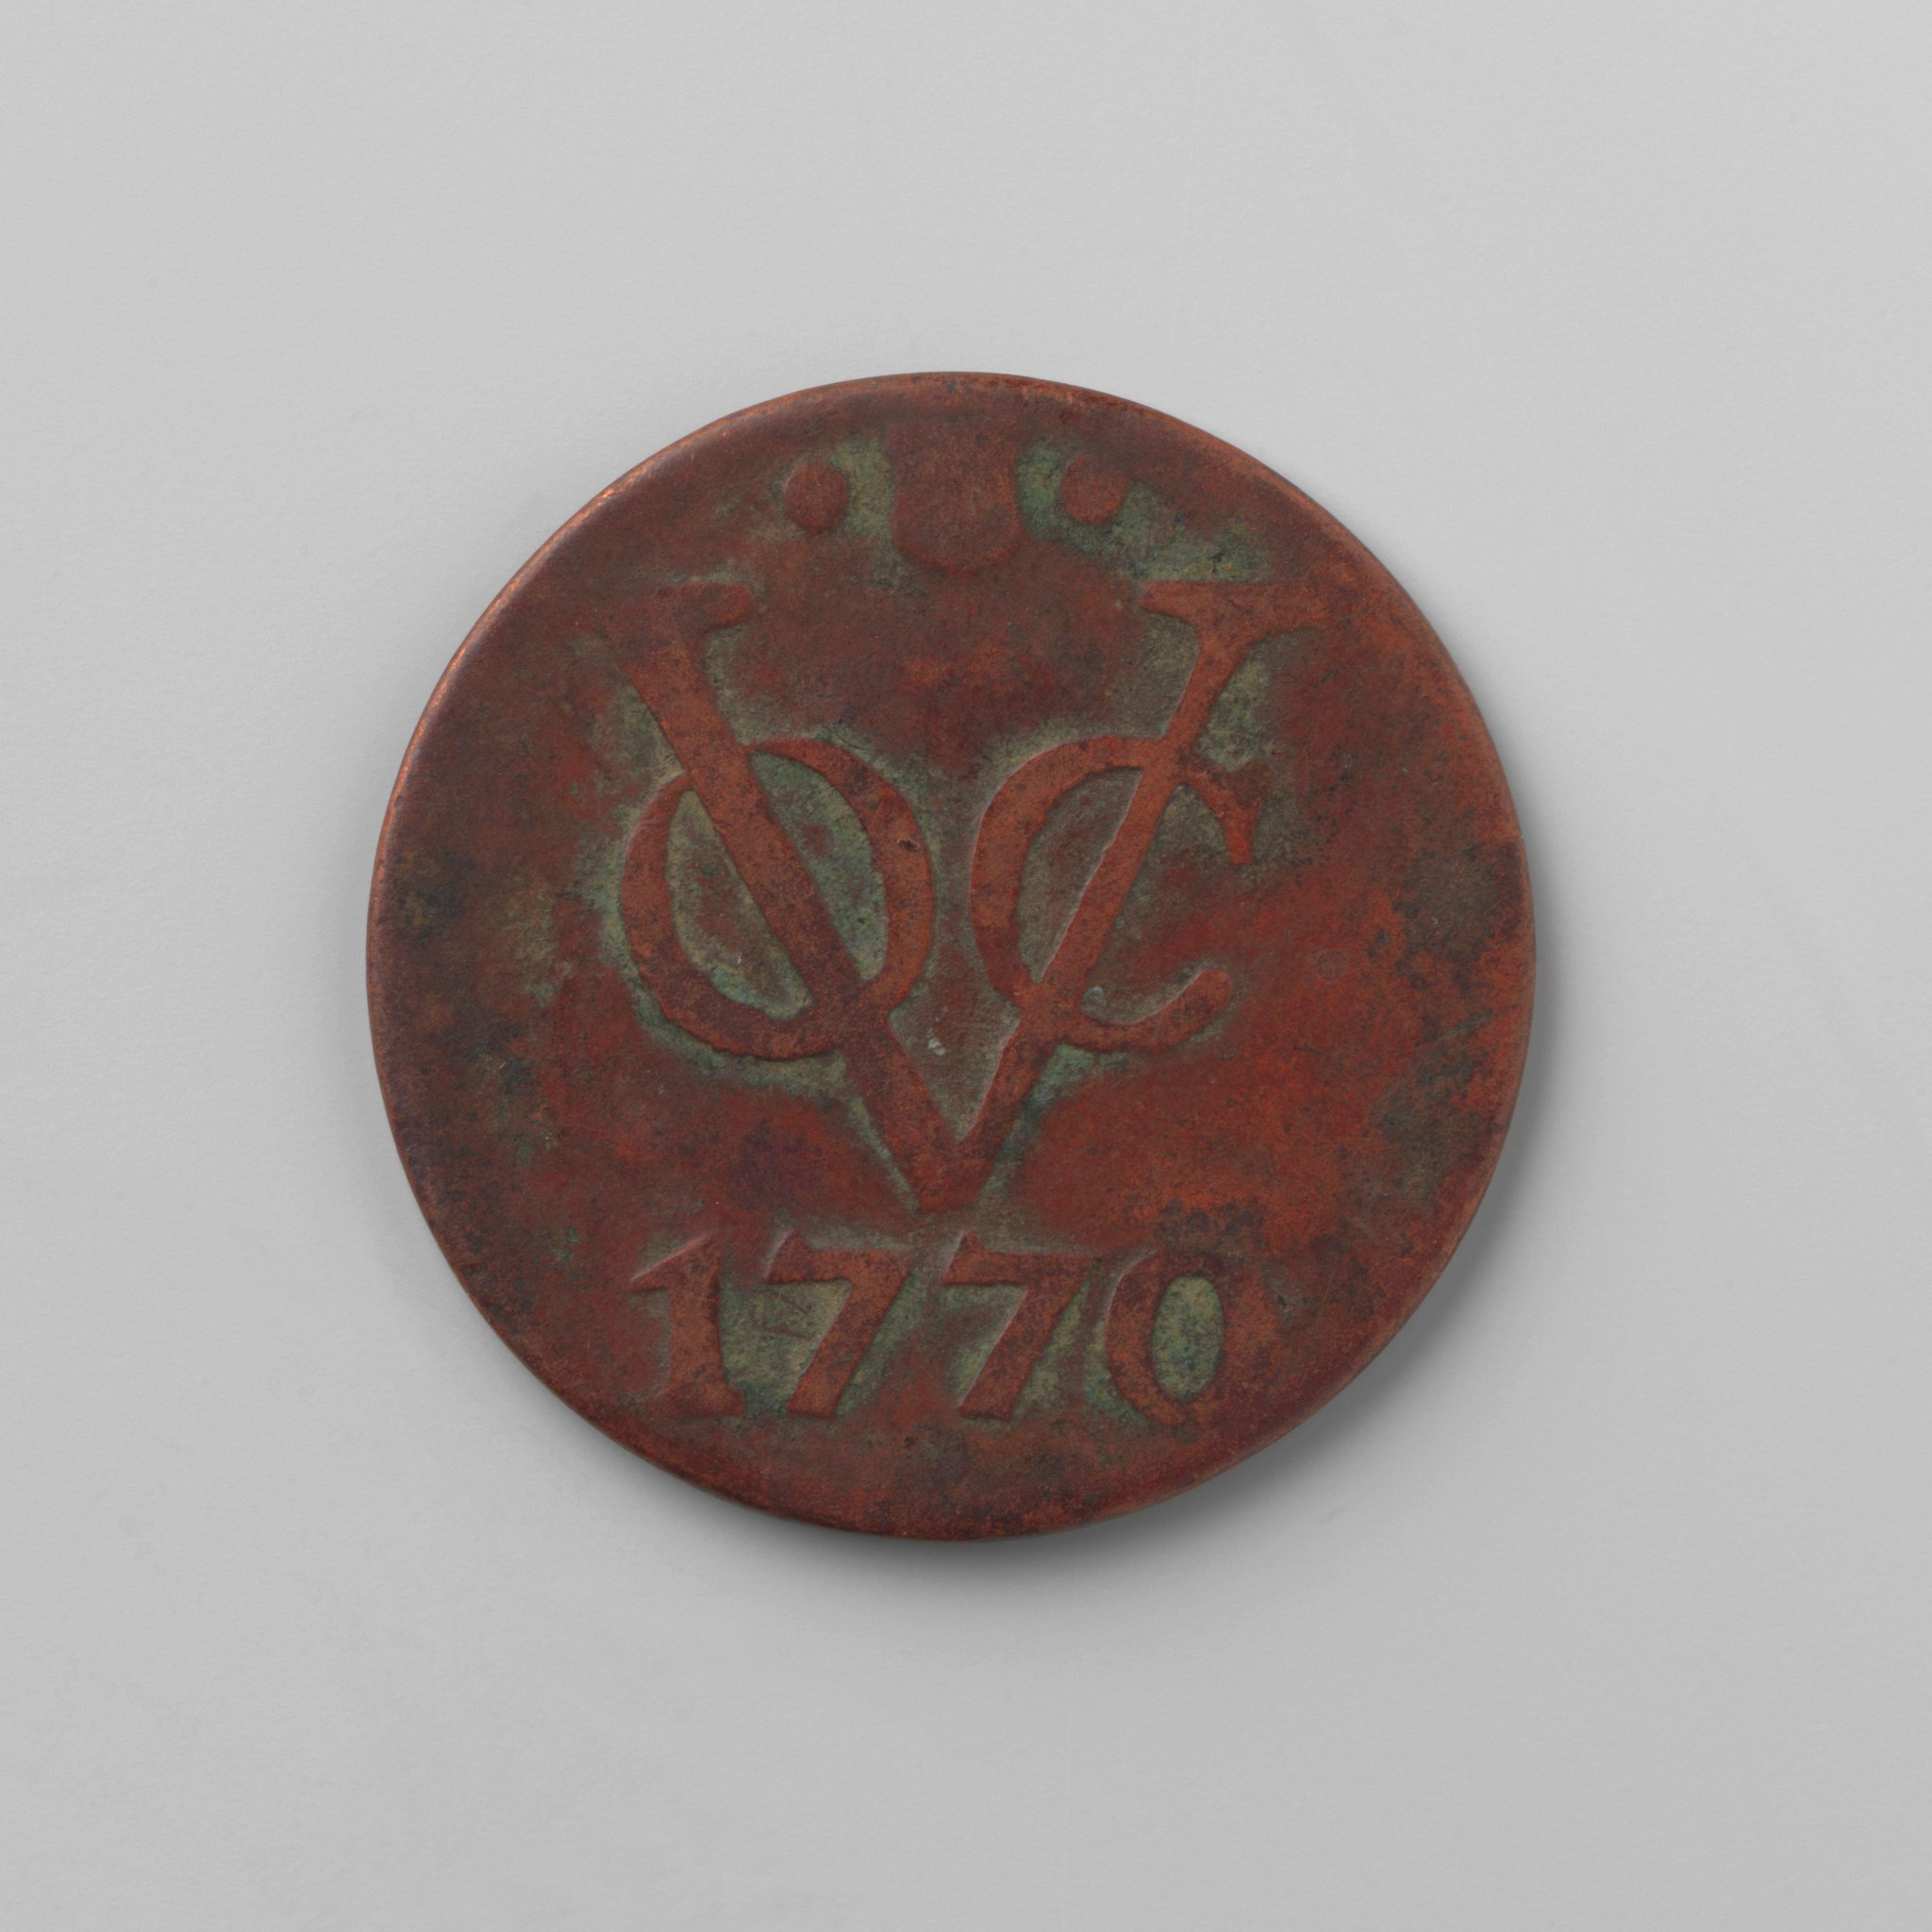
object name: coin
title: Duit van de VOC uit de stad Utrecht,1770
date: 1770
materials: copper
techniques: striking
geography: utrecht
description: Koperen munt. Voorzijde: op balk, waaronder guirlande, geplaatst, door twee leeuwen gehouden gekroond wapenschild van de stad Utrecht. Keerzijde: monogram van de VOC, waarboven muntteken en waaronder jaartal. Gladde rand.